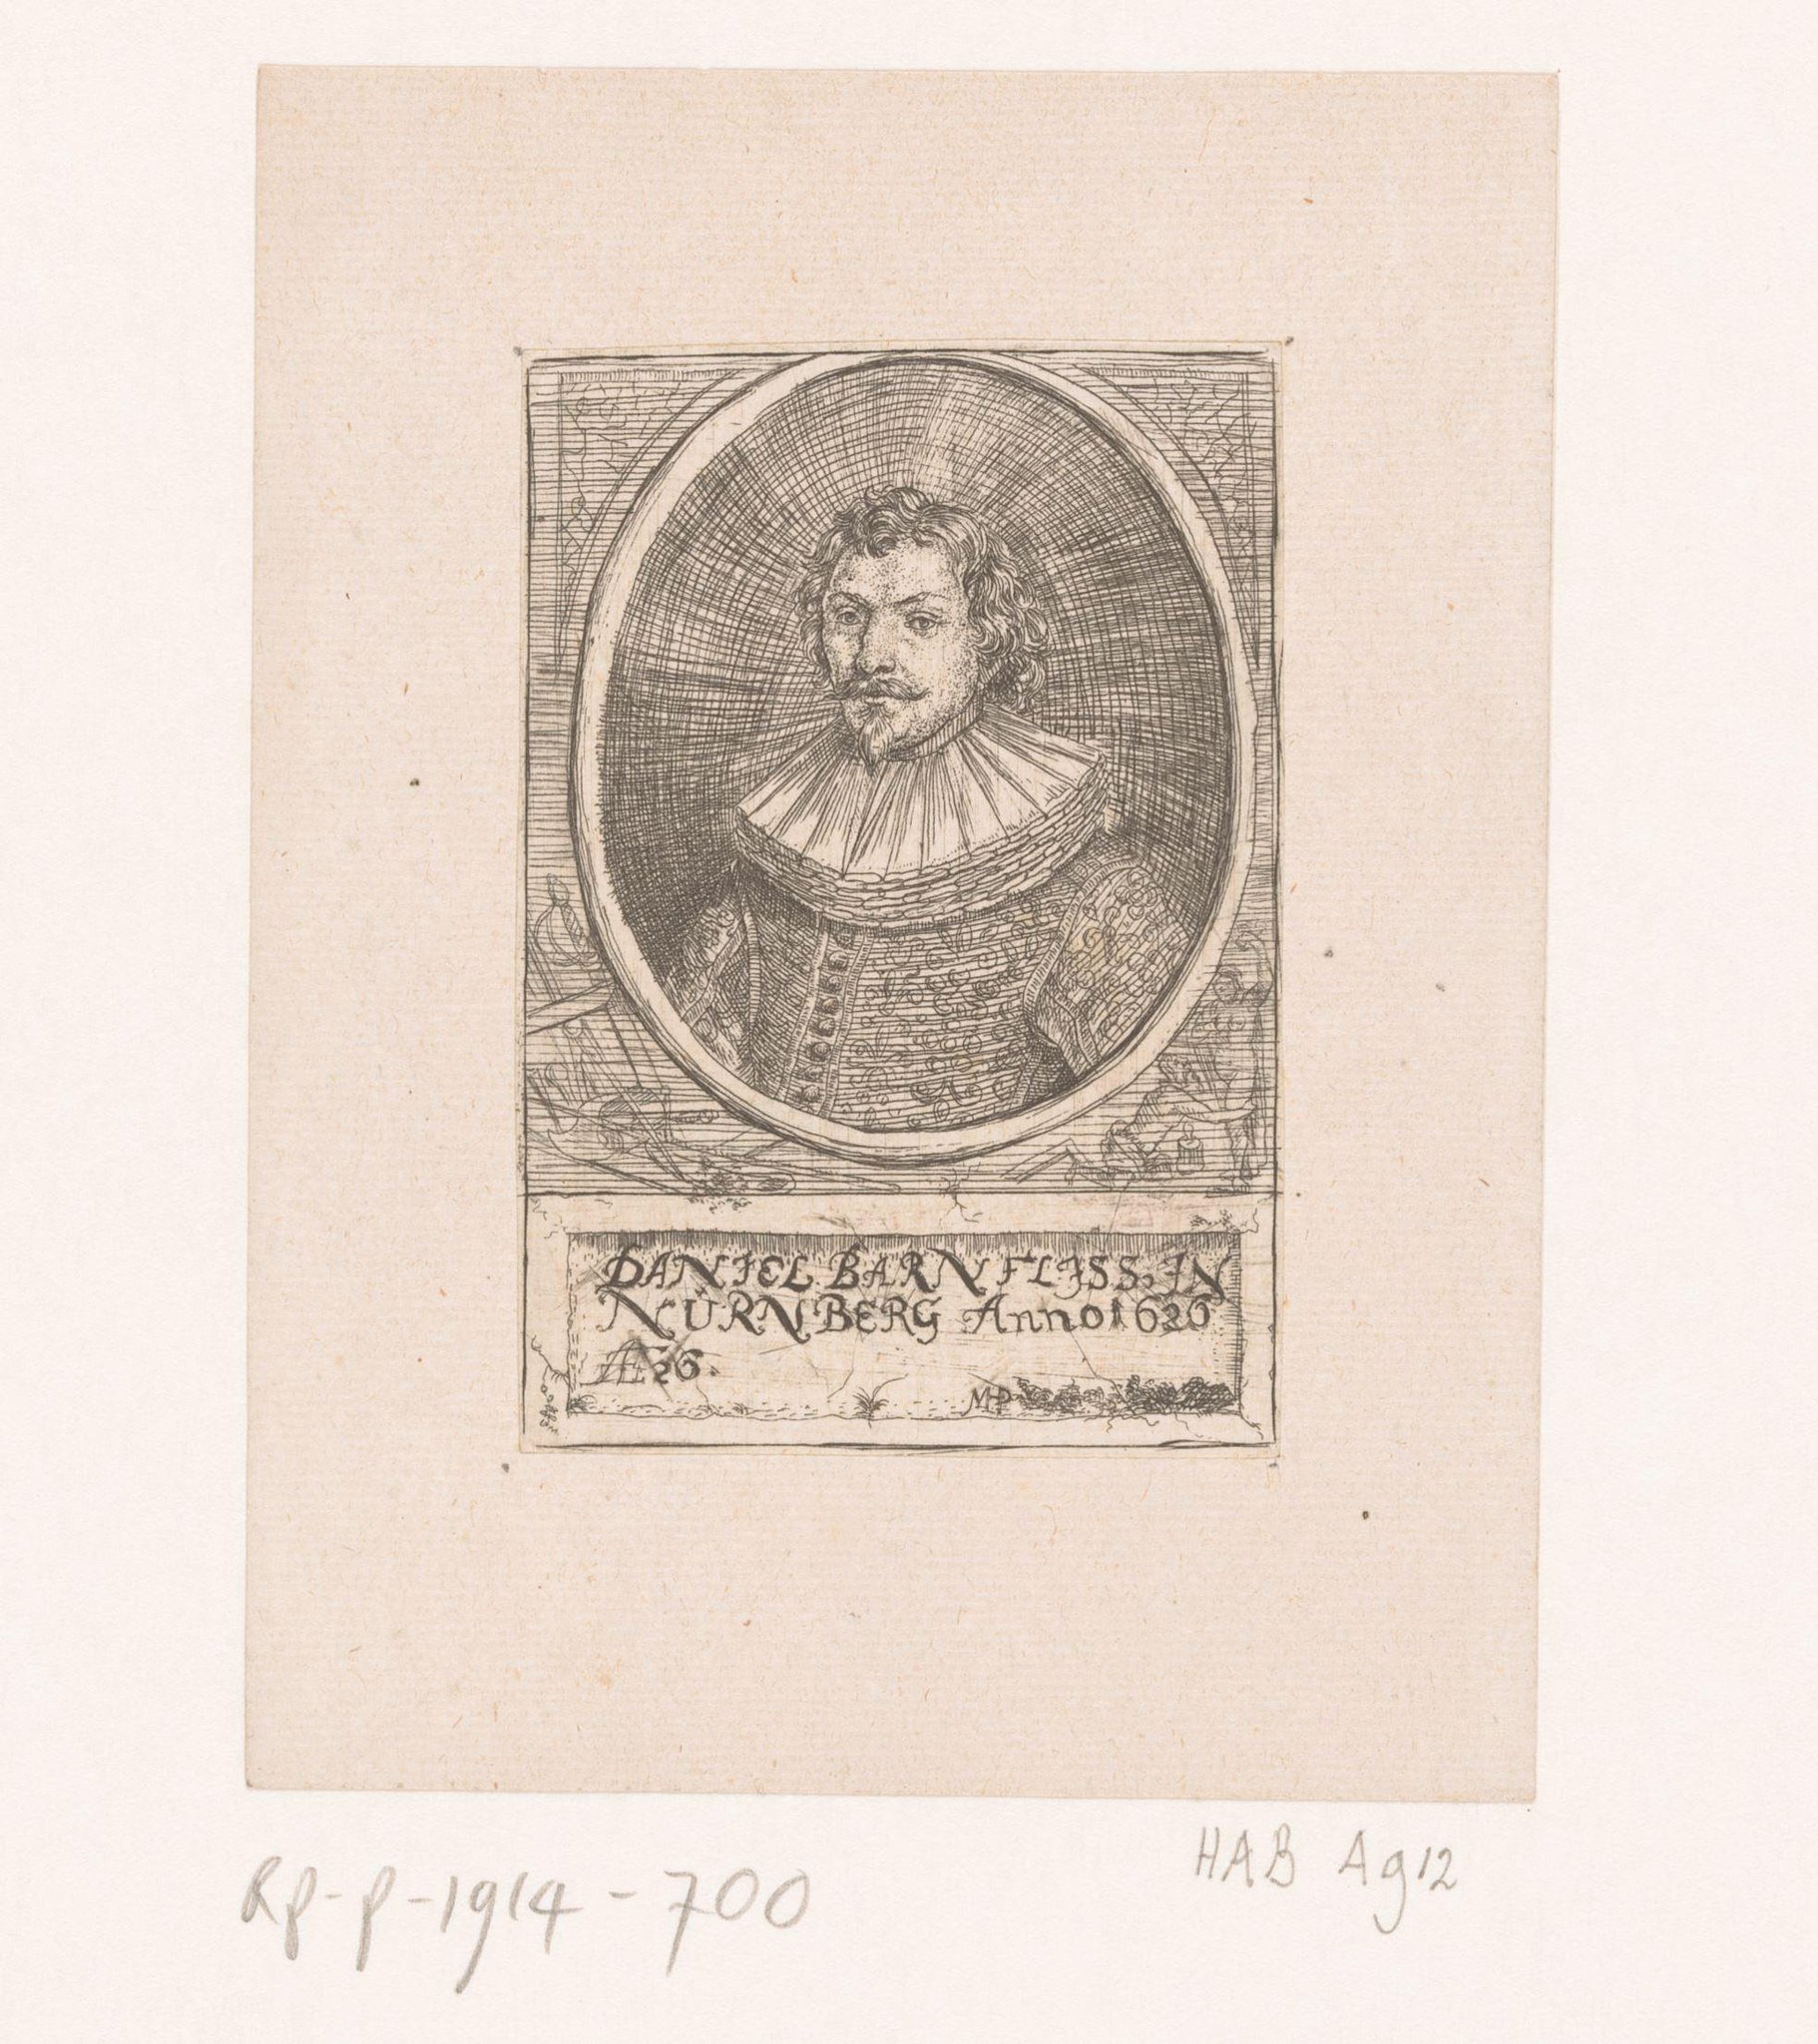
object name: print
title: Portret van Daniel Barnfliss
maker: monogrammist mhp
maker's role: print maker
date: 1626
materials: paper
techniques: etching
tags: sculptor, historical persons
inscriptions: collector's mark: Lugt 2228